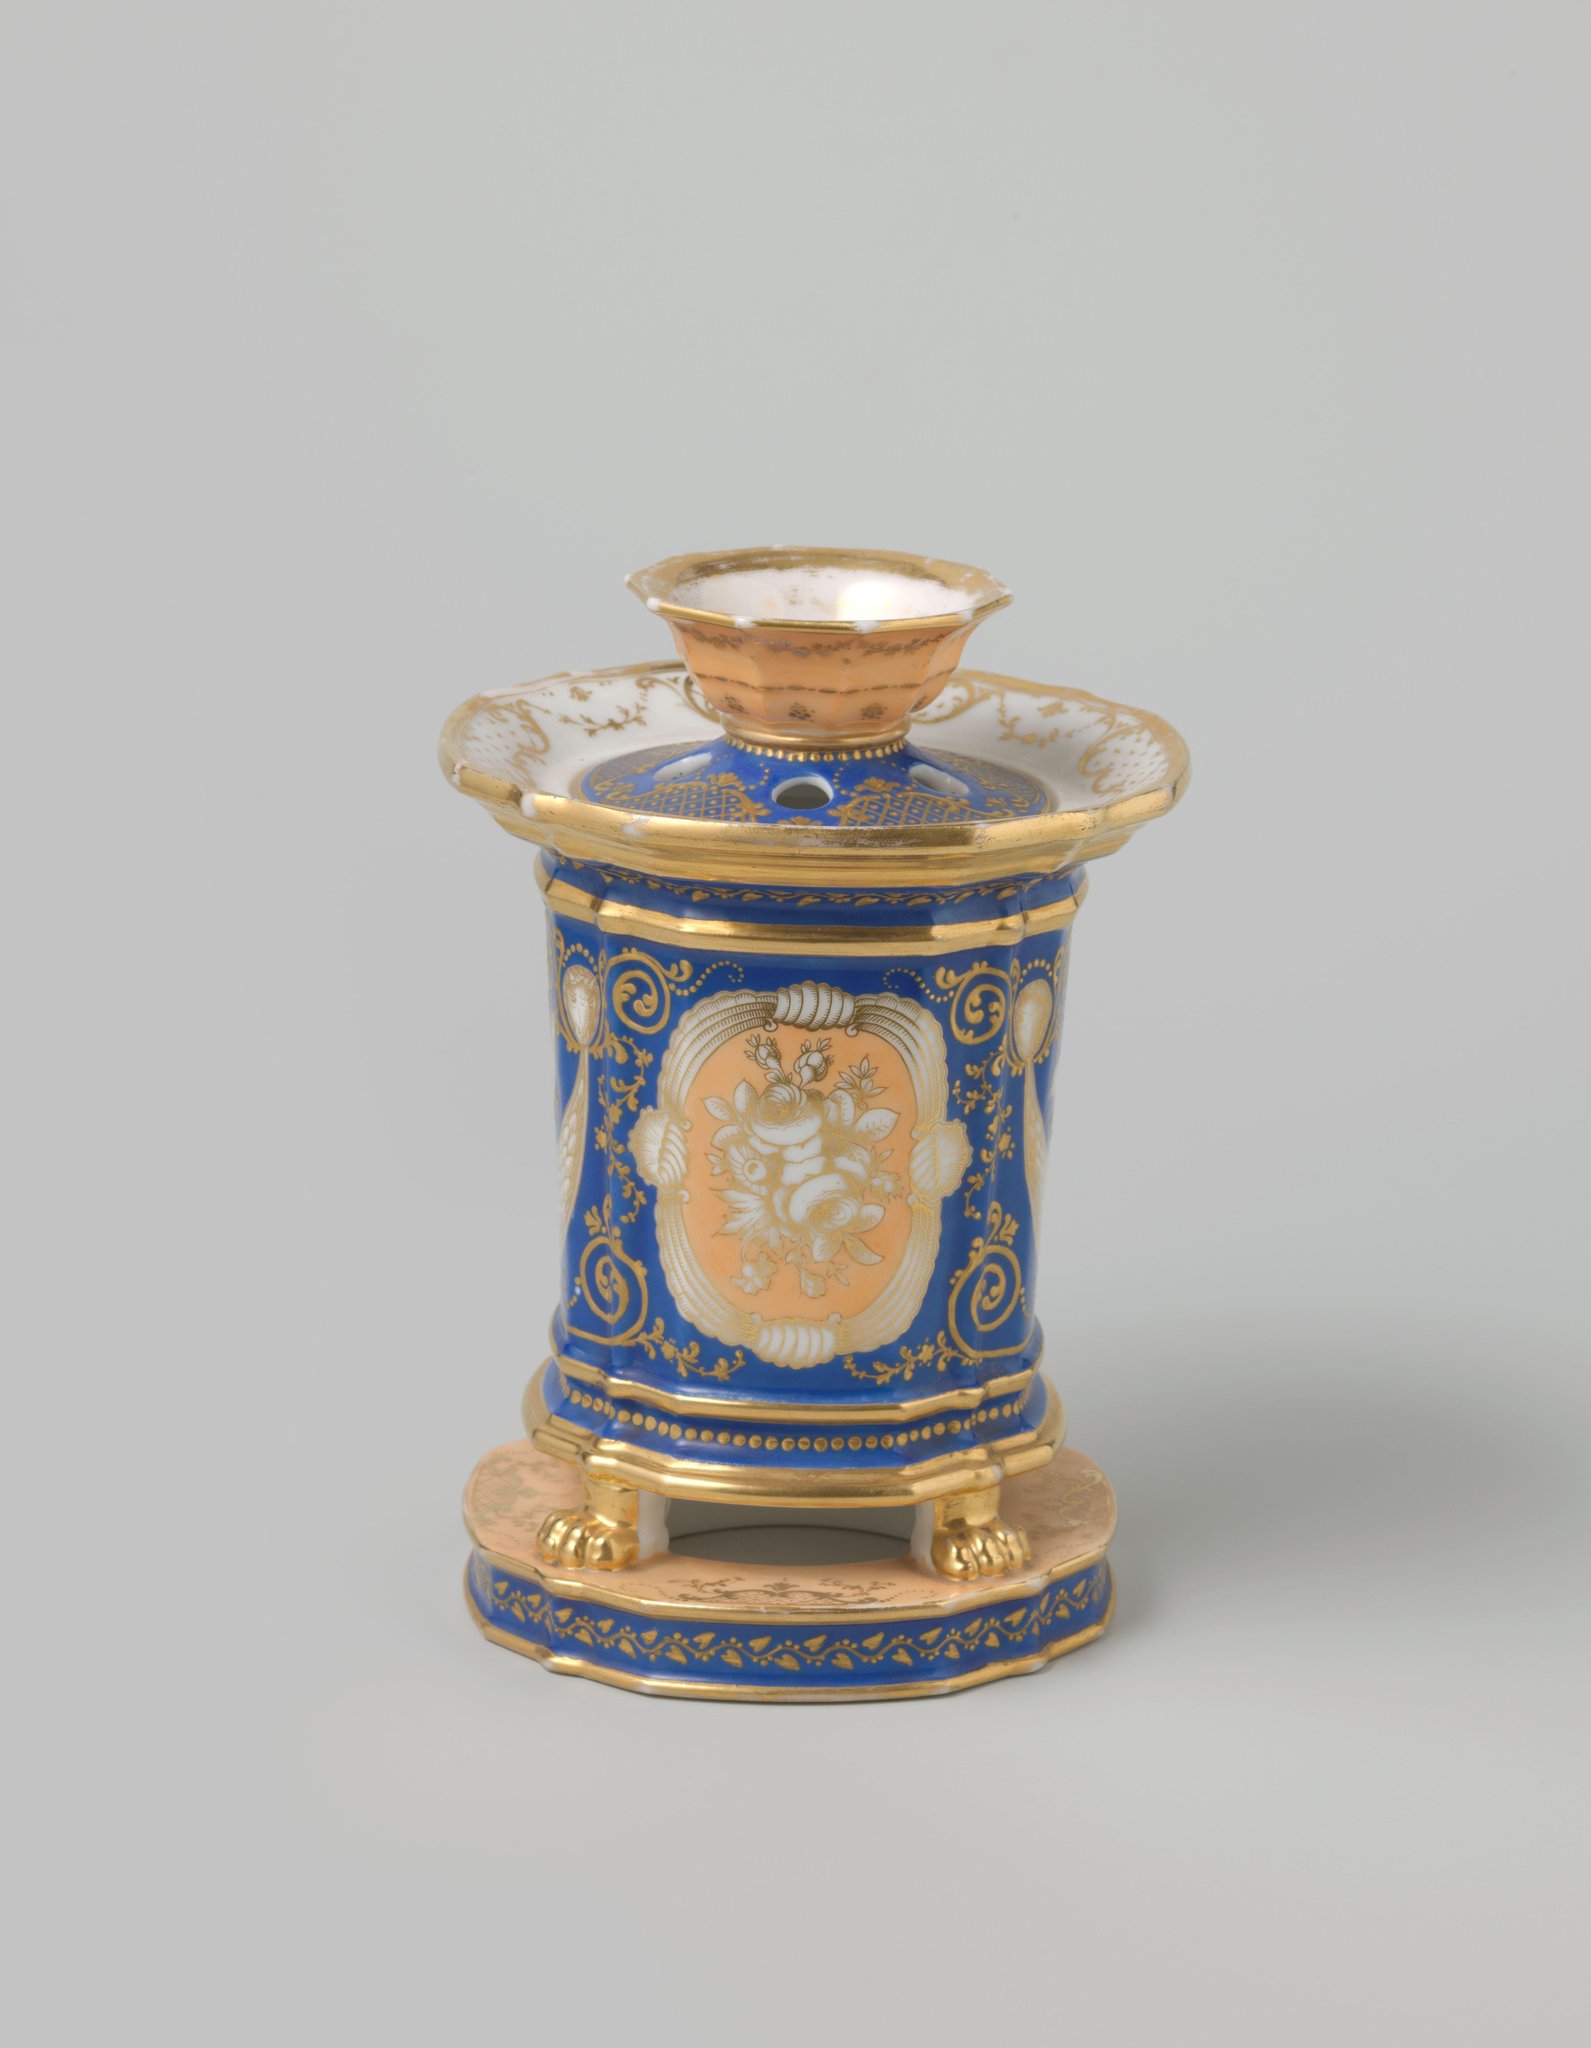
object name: lid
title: Cover of a vase with flowers, scrolls and birds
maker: Anonymous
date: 1800-1899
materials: glaze, gold, paint, porcelain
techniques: firing, forming, gilding, turning, vitrification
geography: france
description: Deksel van een vierzijdige vaas van porselein, beschilderd op het glazuur in blauw, zalmkleur en goud. Op het afneembare bovendeel van de vaas een band met ranken en ruitmotieven, vijf gaten en een tienhoekige kopvorm versierd met guirlandes en bloemkoppen en met een open bodem.